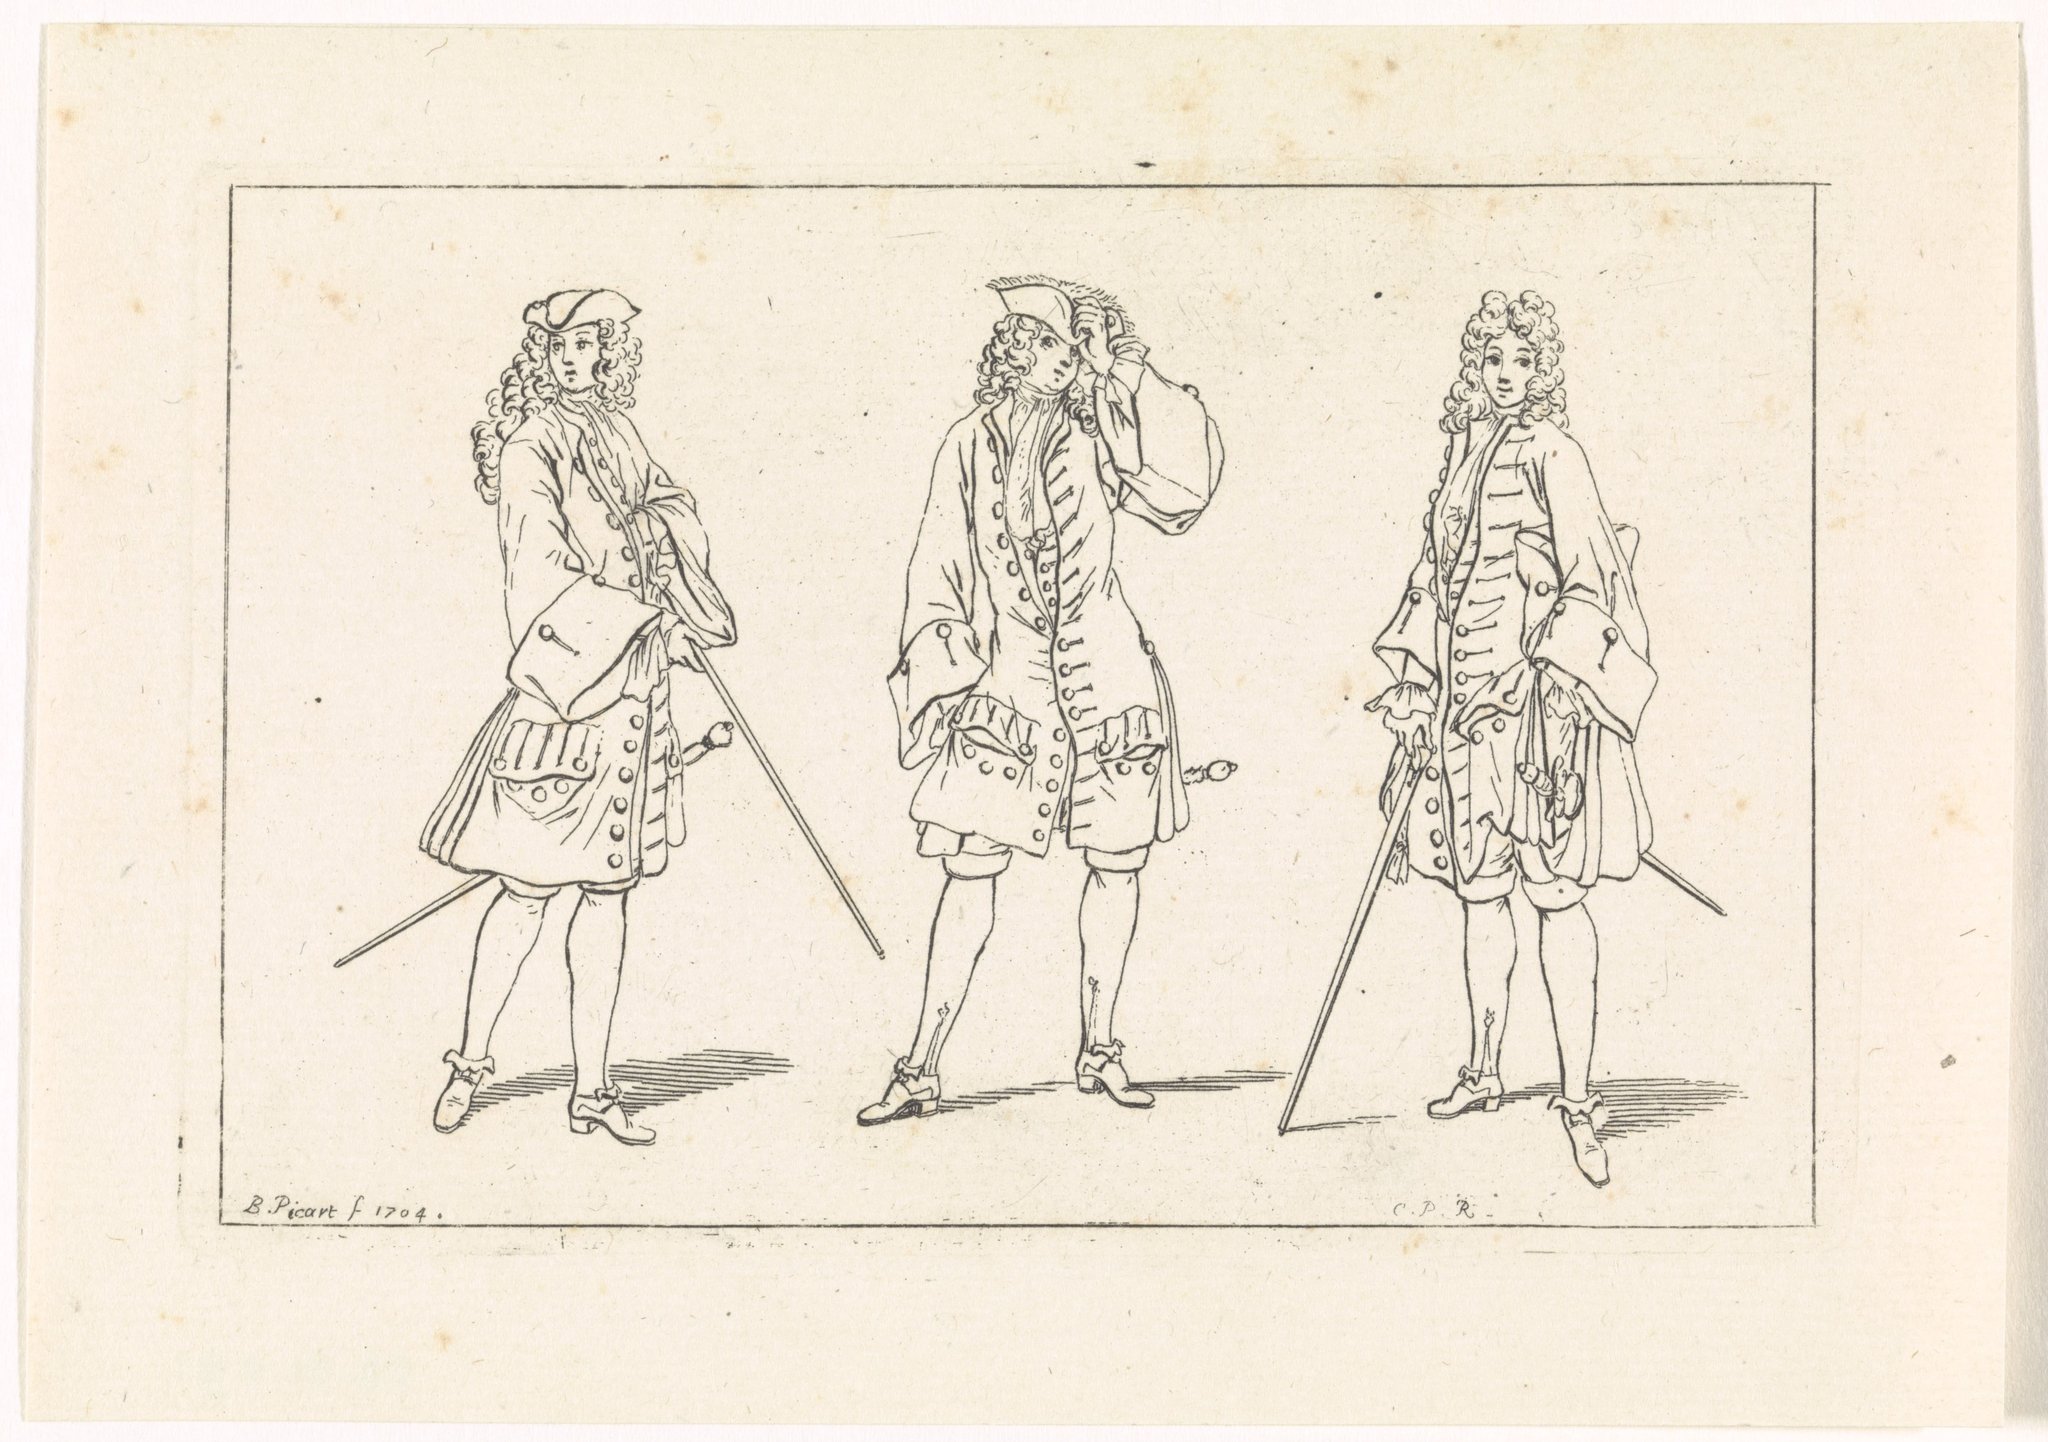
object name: print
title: Verschillende modieuze houdingen van een man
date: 1704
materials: paper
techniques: etching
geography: paris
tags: fashion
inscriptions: date